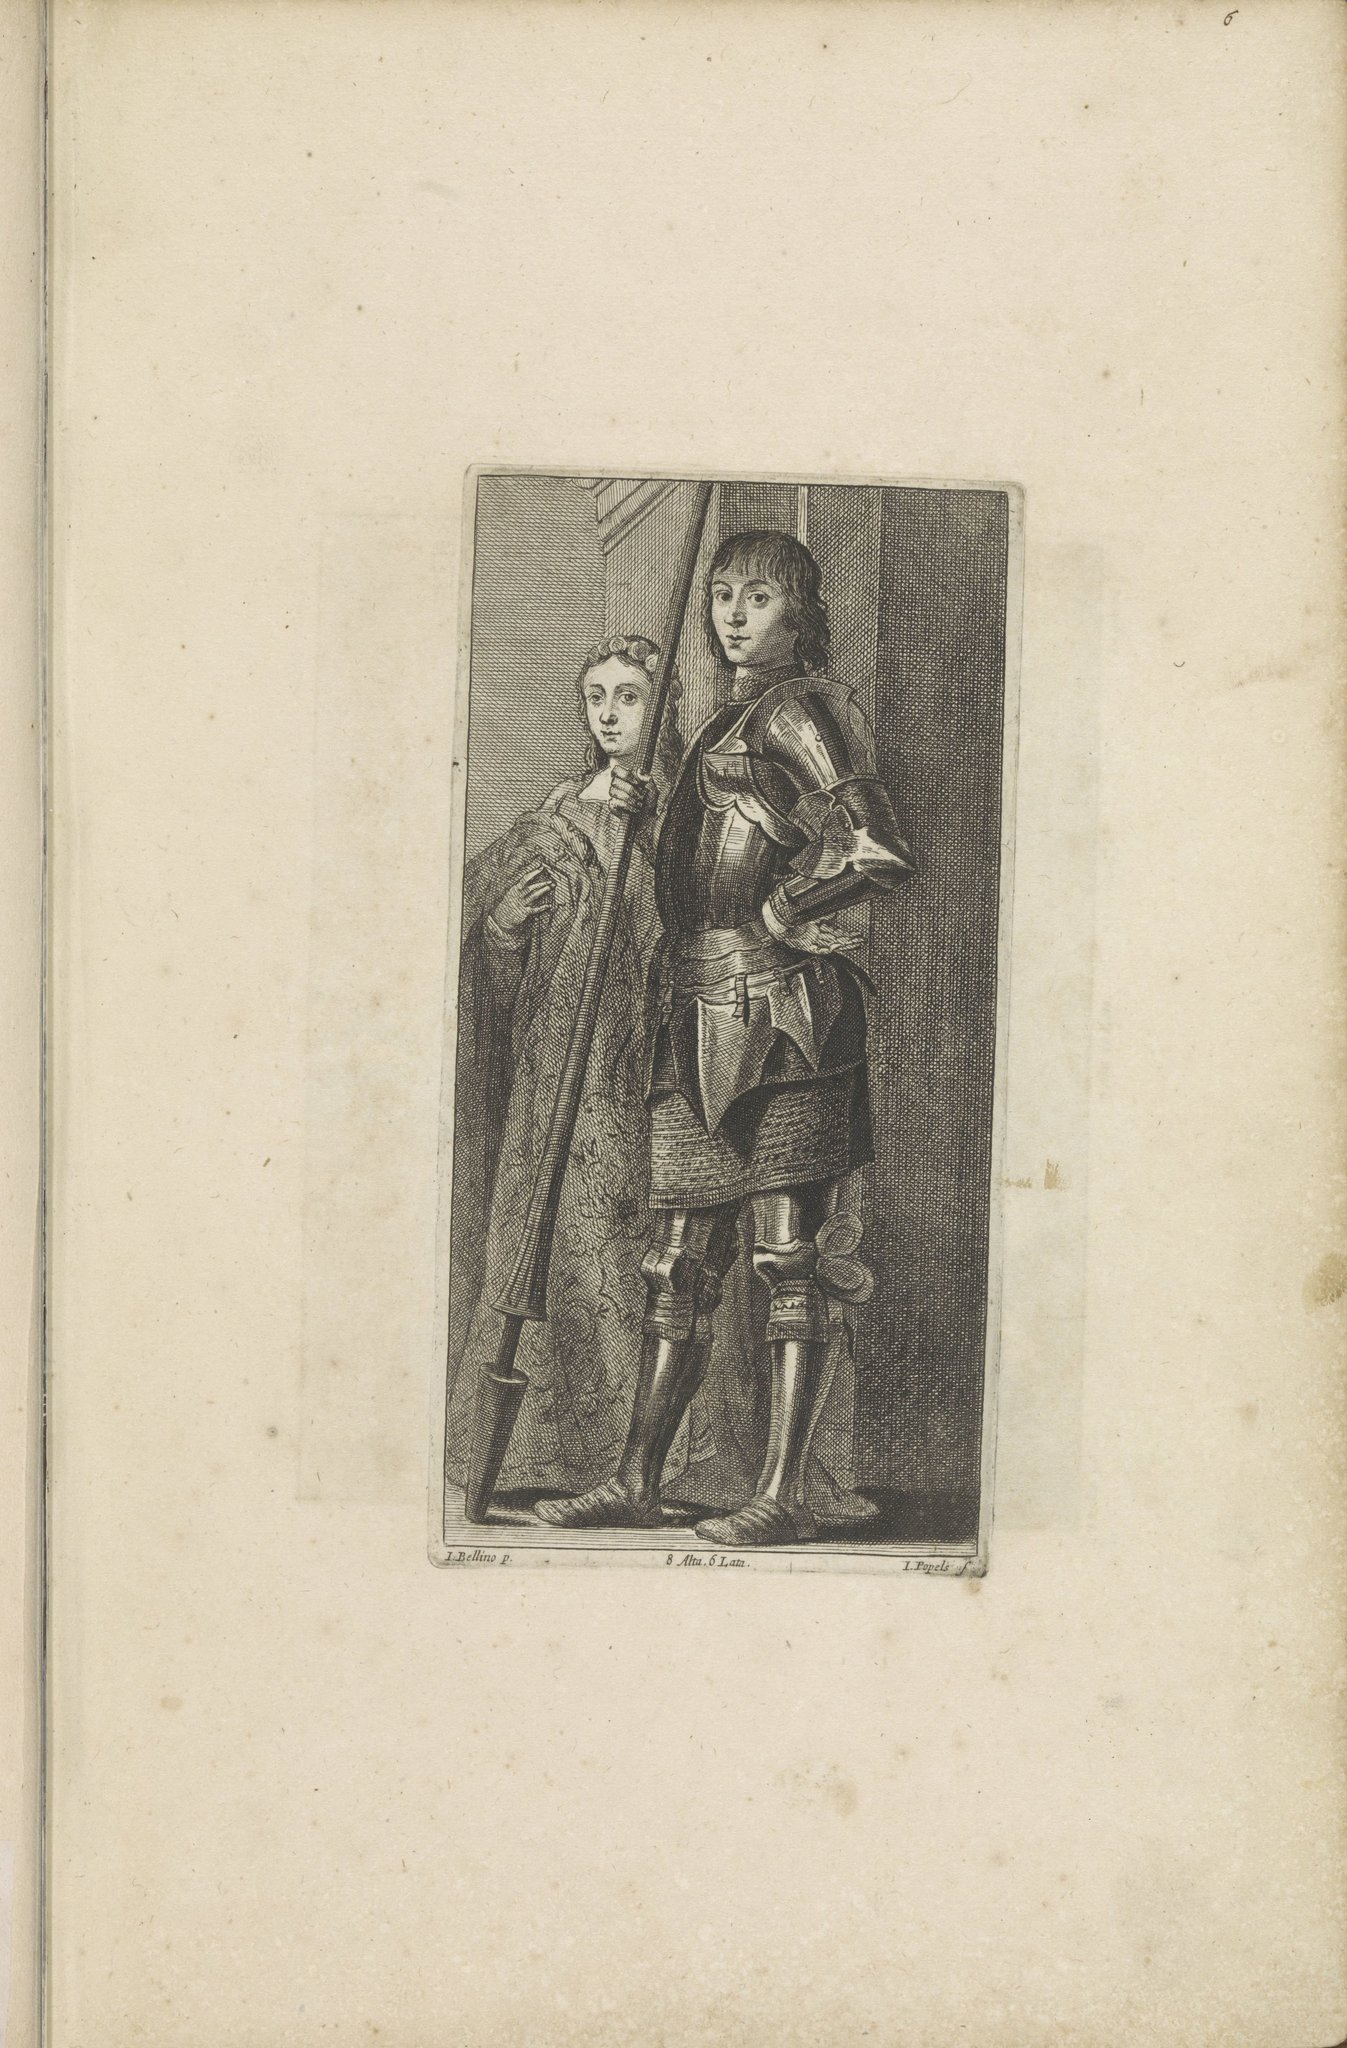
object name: album leaf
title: H. Joris en de H. Cecilia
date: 1660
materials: paper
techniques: etching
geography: antwerp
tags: the virgin martyr cecilia of rome; possible attributes: falcon, musical instruments, organ, wreath of roses and lilies, female saints, the warrior martyr george (georgius); possible attributes: banner (red cross on white field), (red) cross, dragon, (white) horse, broken lance, shield (with cross), sword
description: David Teniers heeft waarschijnlijk van alle schilderijen uit de collectie van Leopold Willem van Oostenrijk een olieverfstudie op doek of paneel vervaardigd (zgn. pasticcio), die als voorbeeld voor de prentmakers diende. Het is niet altijd duidelijk of de pasticci door hem zijn gemaakt of door zijn atelier. Niet alle pasticci zijn overgeleverd.